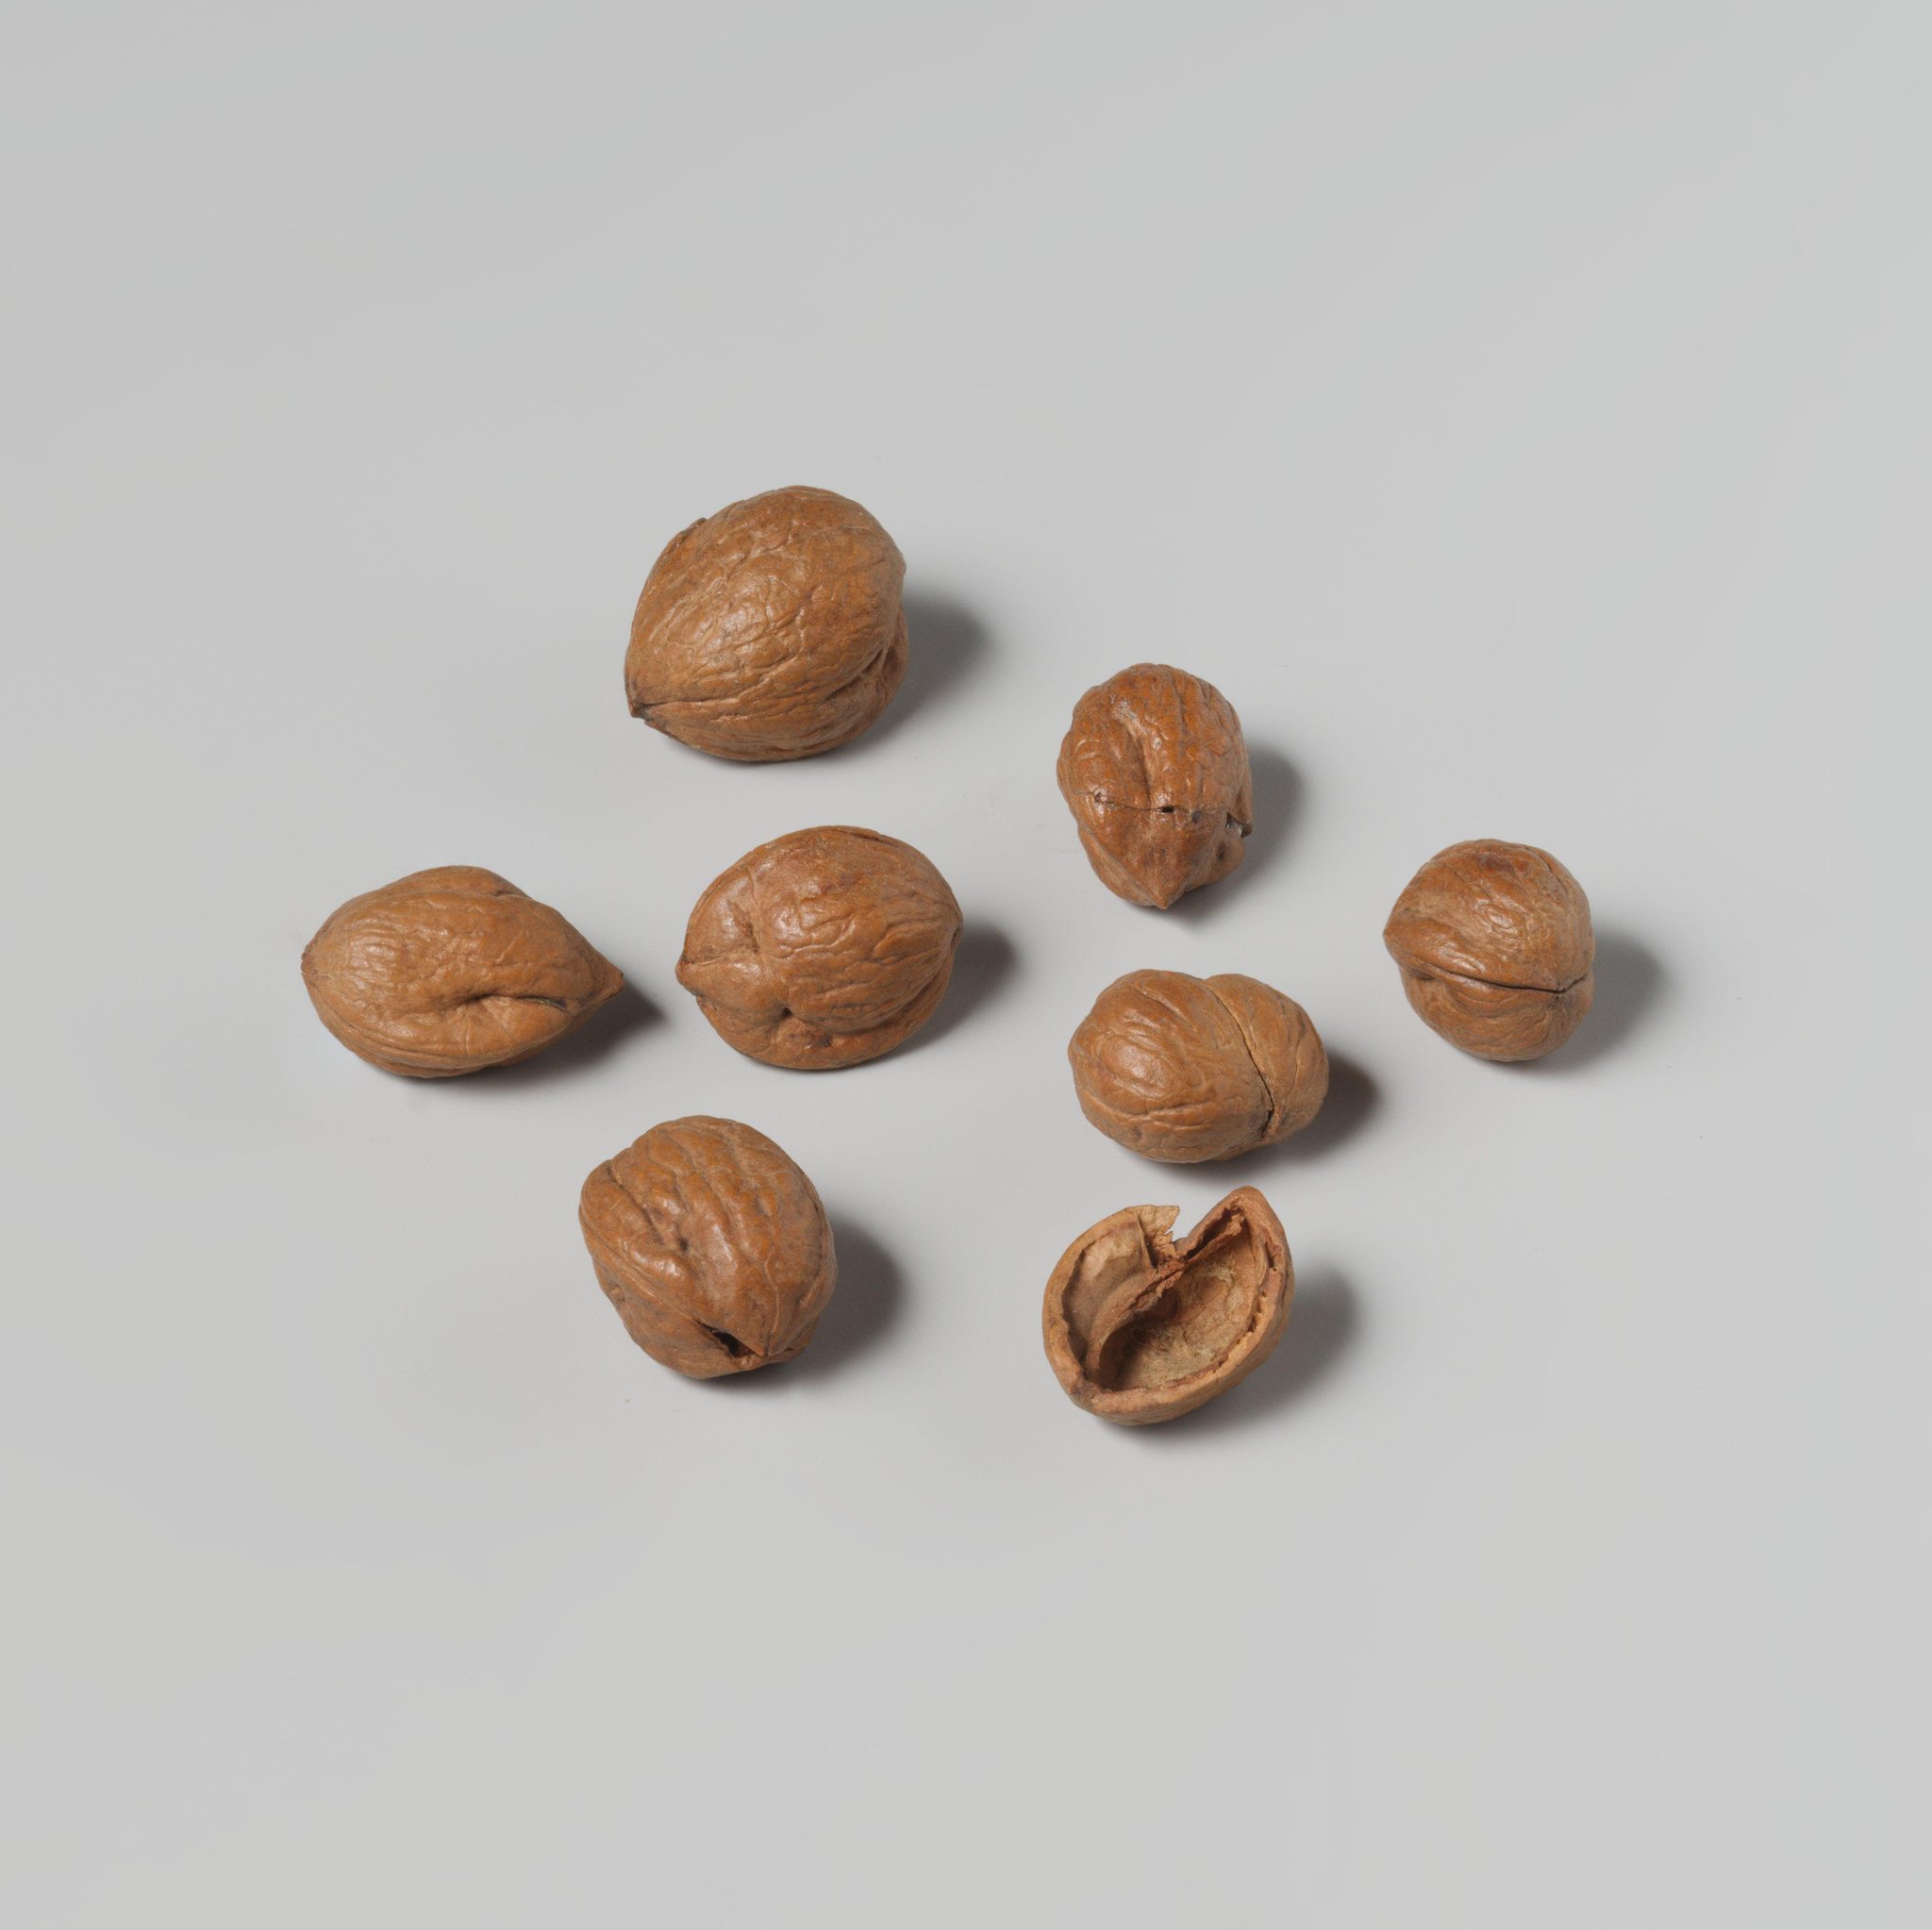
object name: nut plant material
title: Zeven walnoten en een lege dop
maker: niet van toepassing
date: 1675-1899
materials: nut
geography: netherlands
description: Zeven walnoten en een lege dop, behorend tot de voorraad van het poppenhuis Dunois.